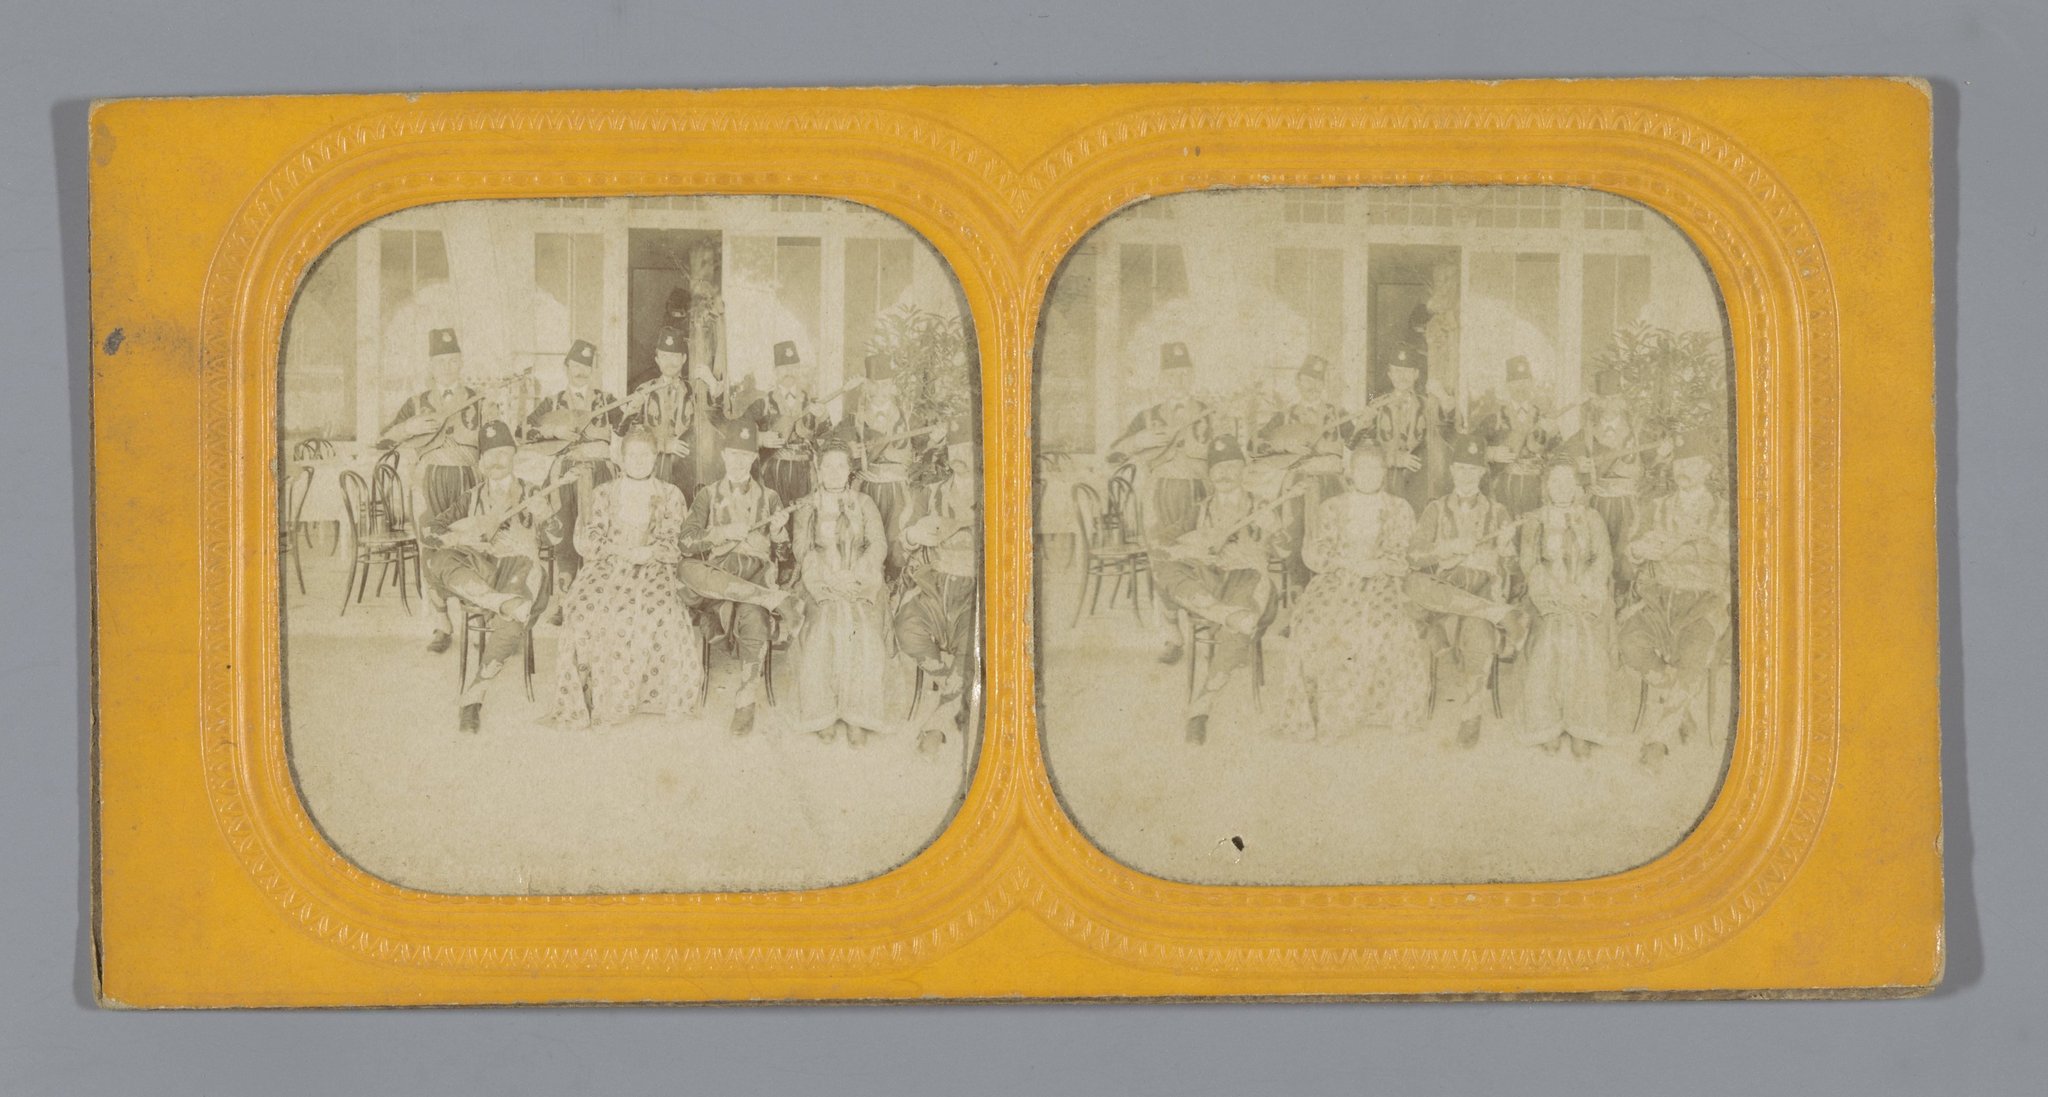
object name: tissue stereograph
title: Exposition 1900, Musiciens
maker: Anonymous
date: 1900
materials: cardboard, paper, photographic support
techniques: albumen print, hand coloring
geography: paris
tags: more than one musician with instrument, paris